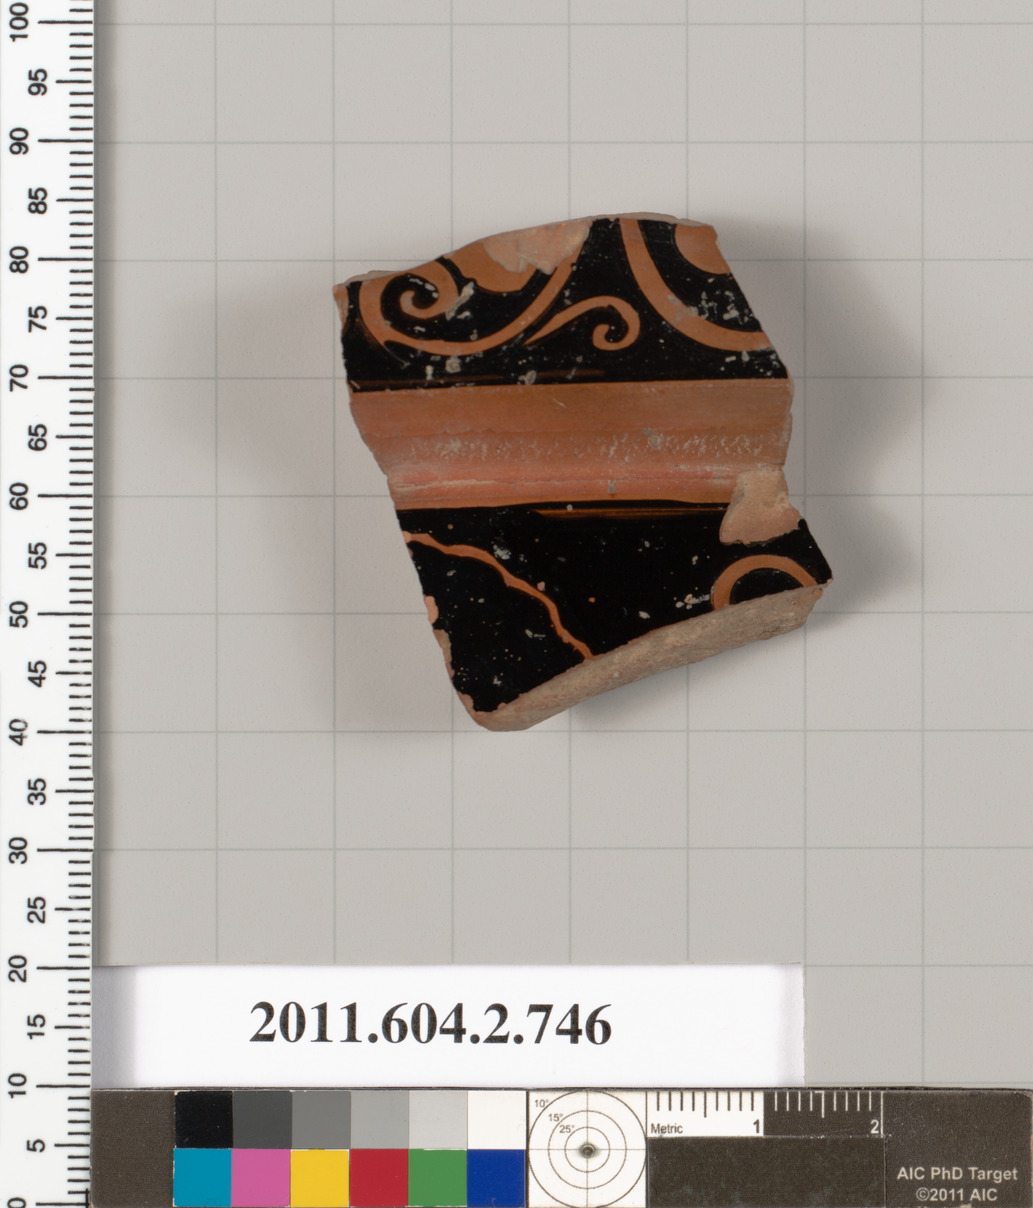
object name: calyx krater fragment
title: Terracotta fragment of a calyx-krater (bowl for mixing wine and water)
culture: greek, attic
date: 520-510 BCE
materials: terracotta